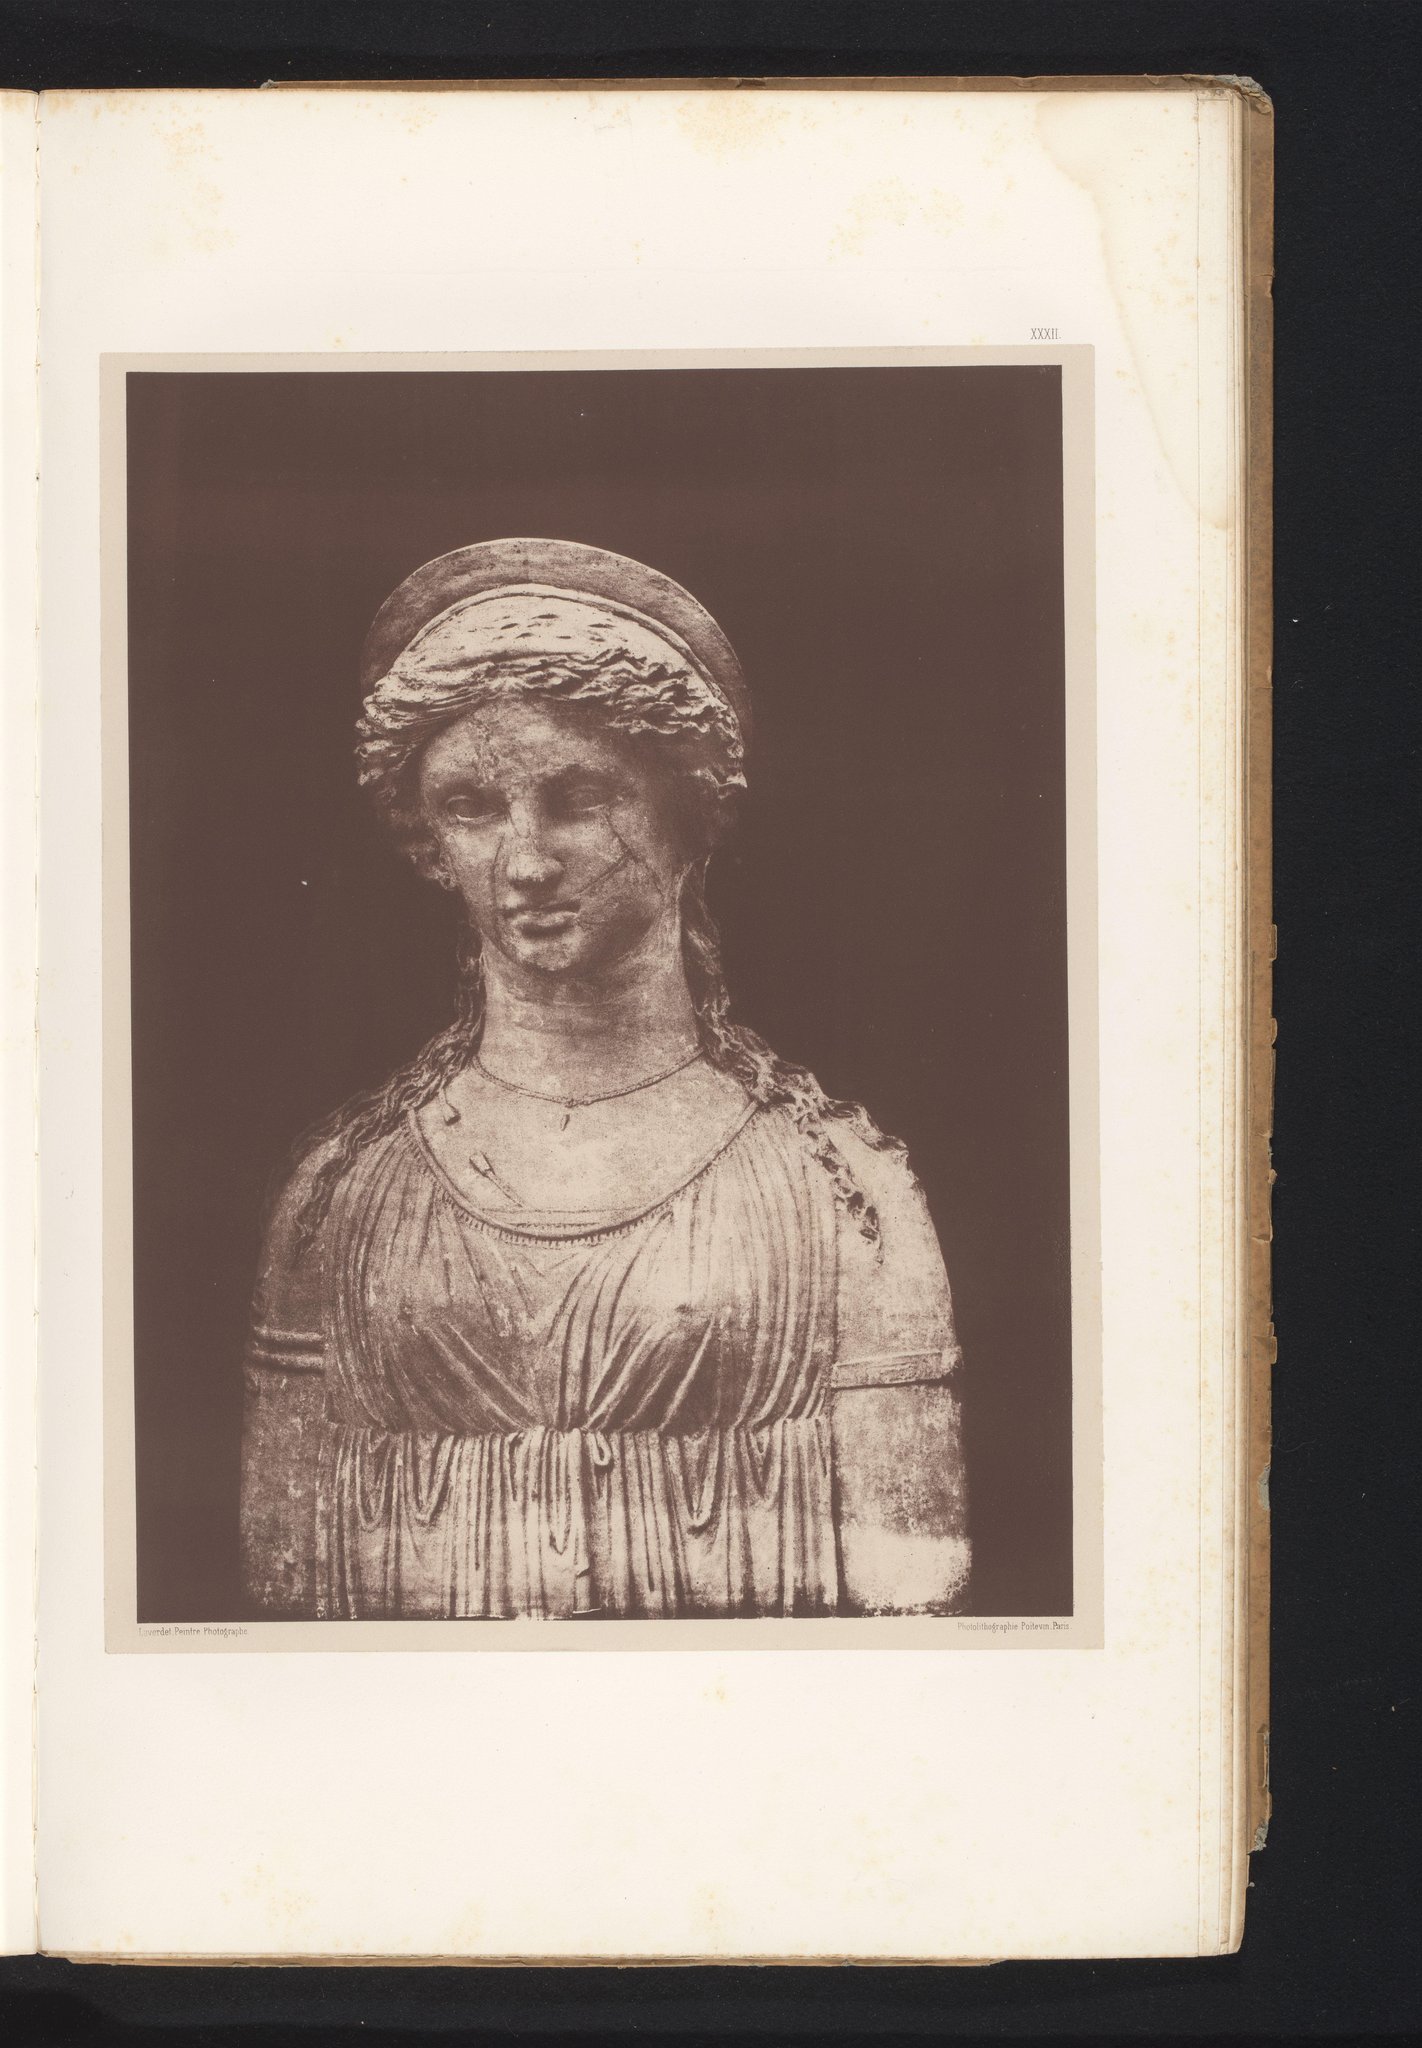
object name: page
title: Terracotta sculptuur van een buste van een vrouw met diadeem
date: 1852-1857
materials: paper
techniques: photolithography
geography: paris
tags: adult woman, piece of sculpture, reproduction of a piece of sculpture (+ clay, sand, etc. ~ arts), diadem, tiara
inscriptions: number: ‘XXXII.’